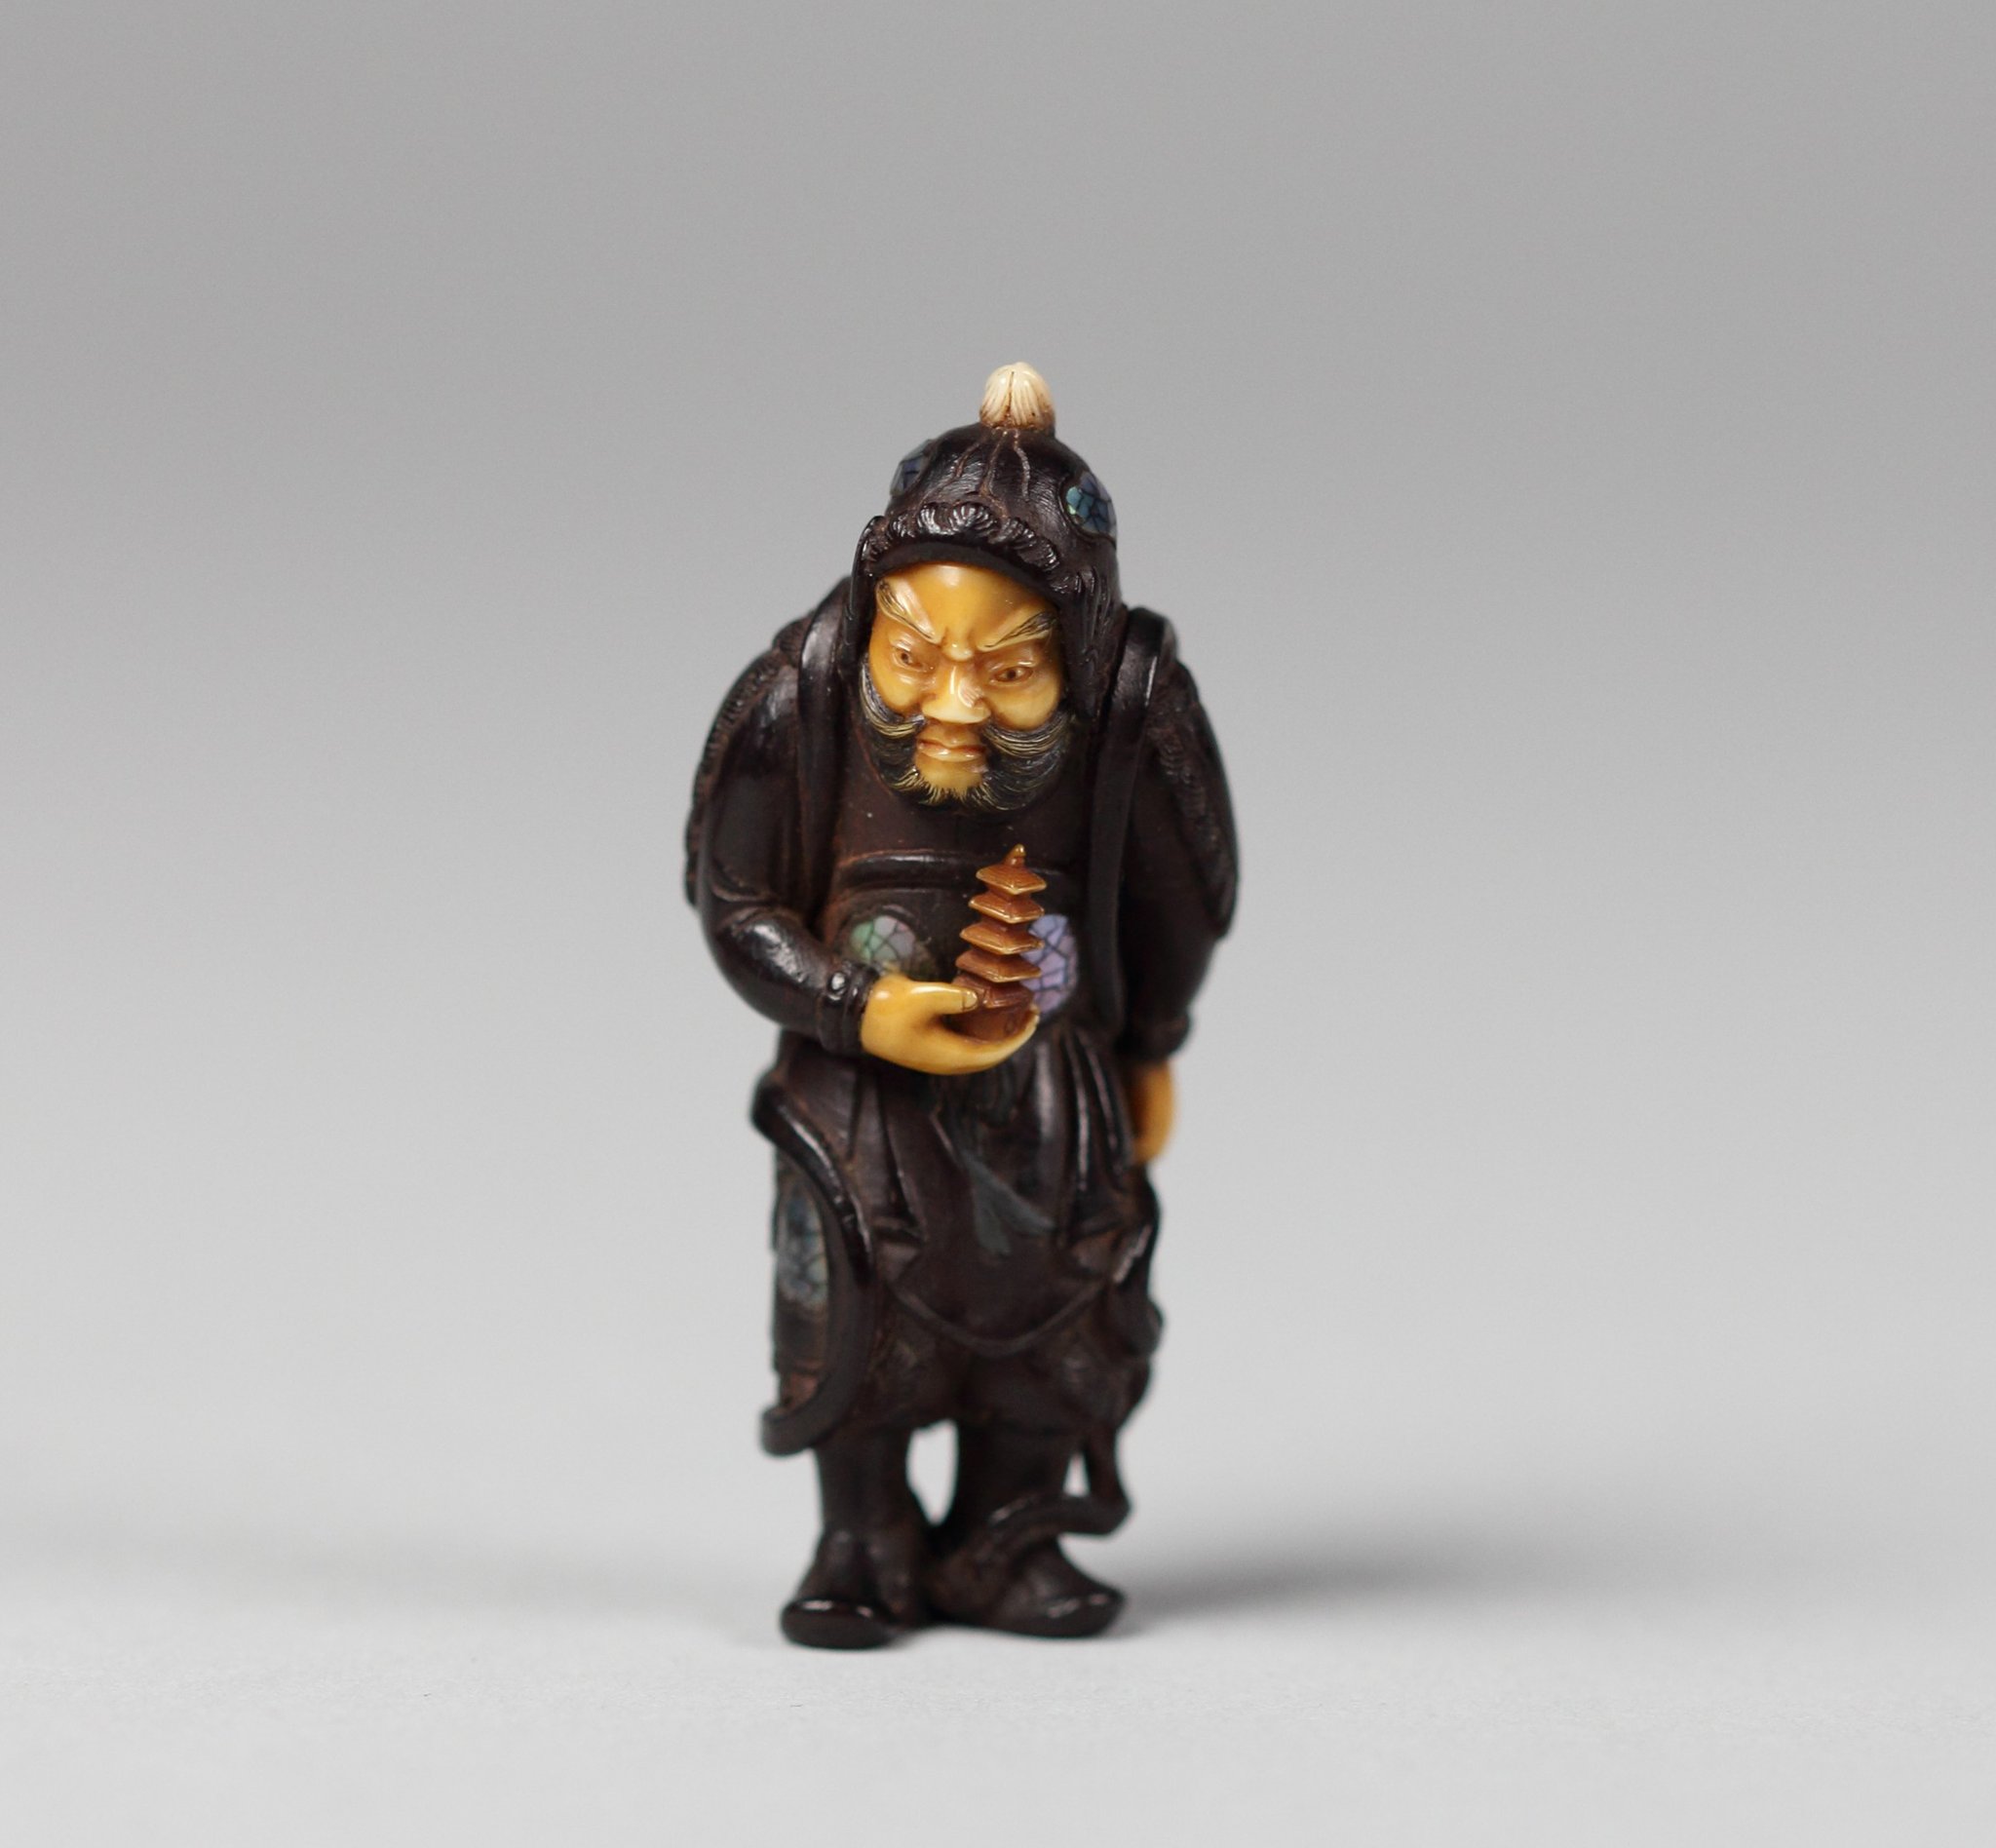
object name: netsuke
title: Netsuke of Bishamon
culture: japanese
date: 1801-1900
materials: ivory, wood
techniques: inlay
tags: men,pagodas